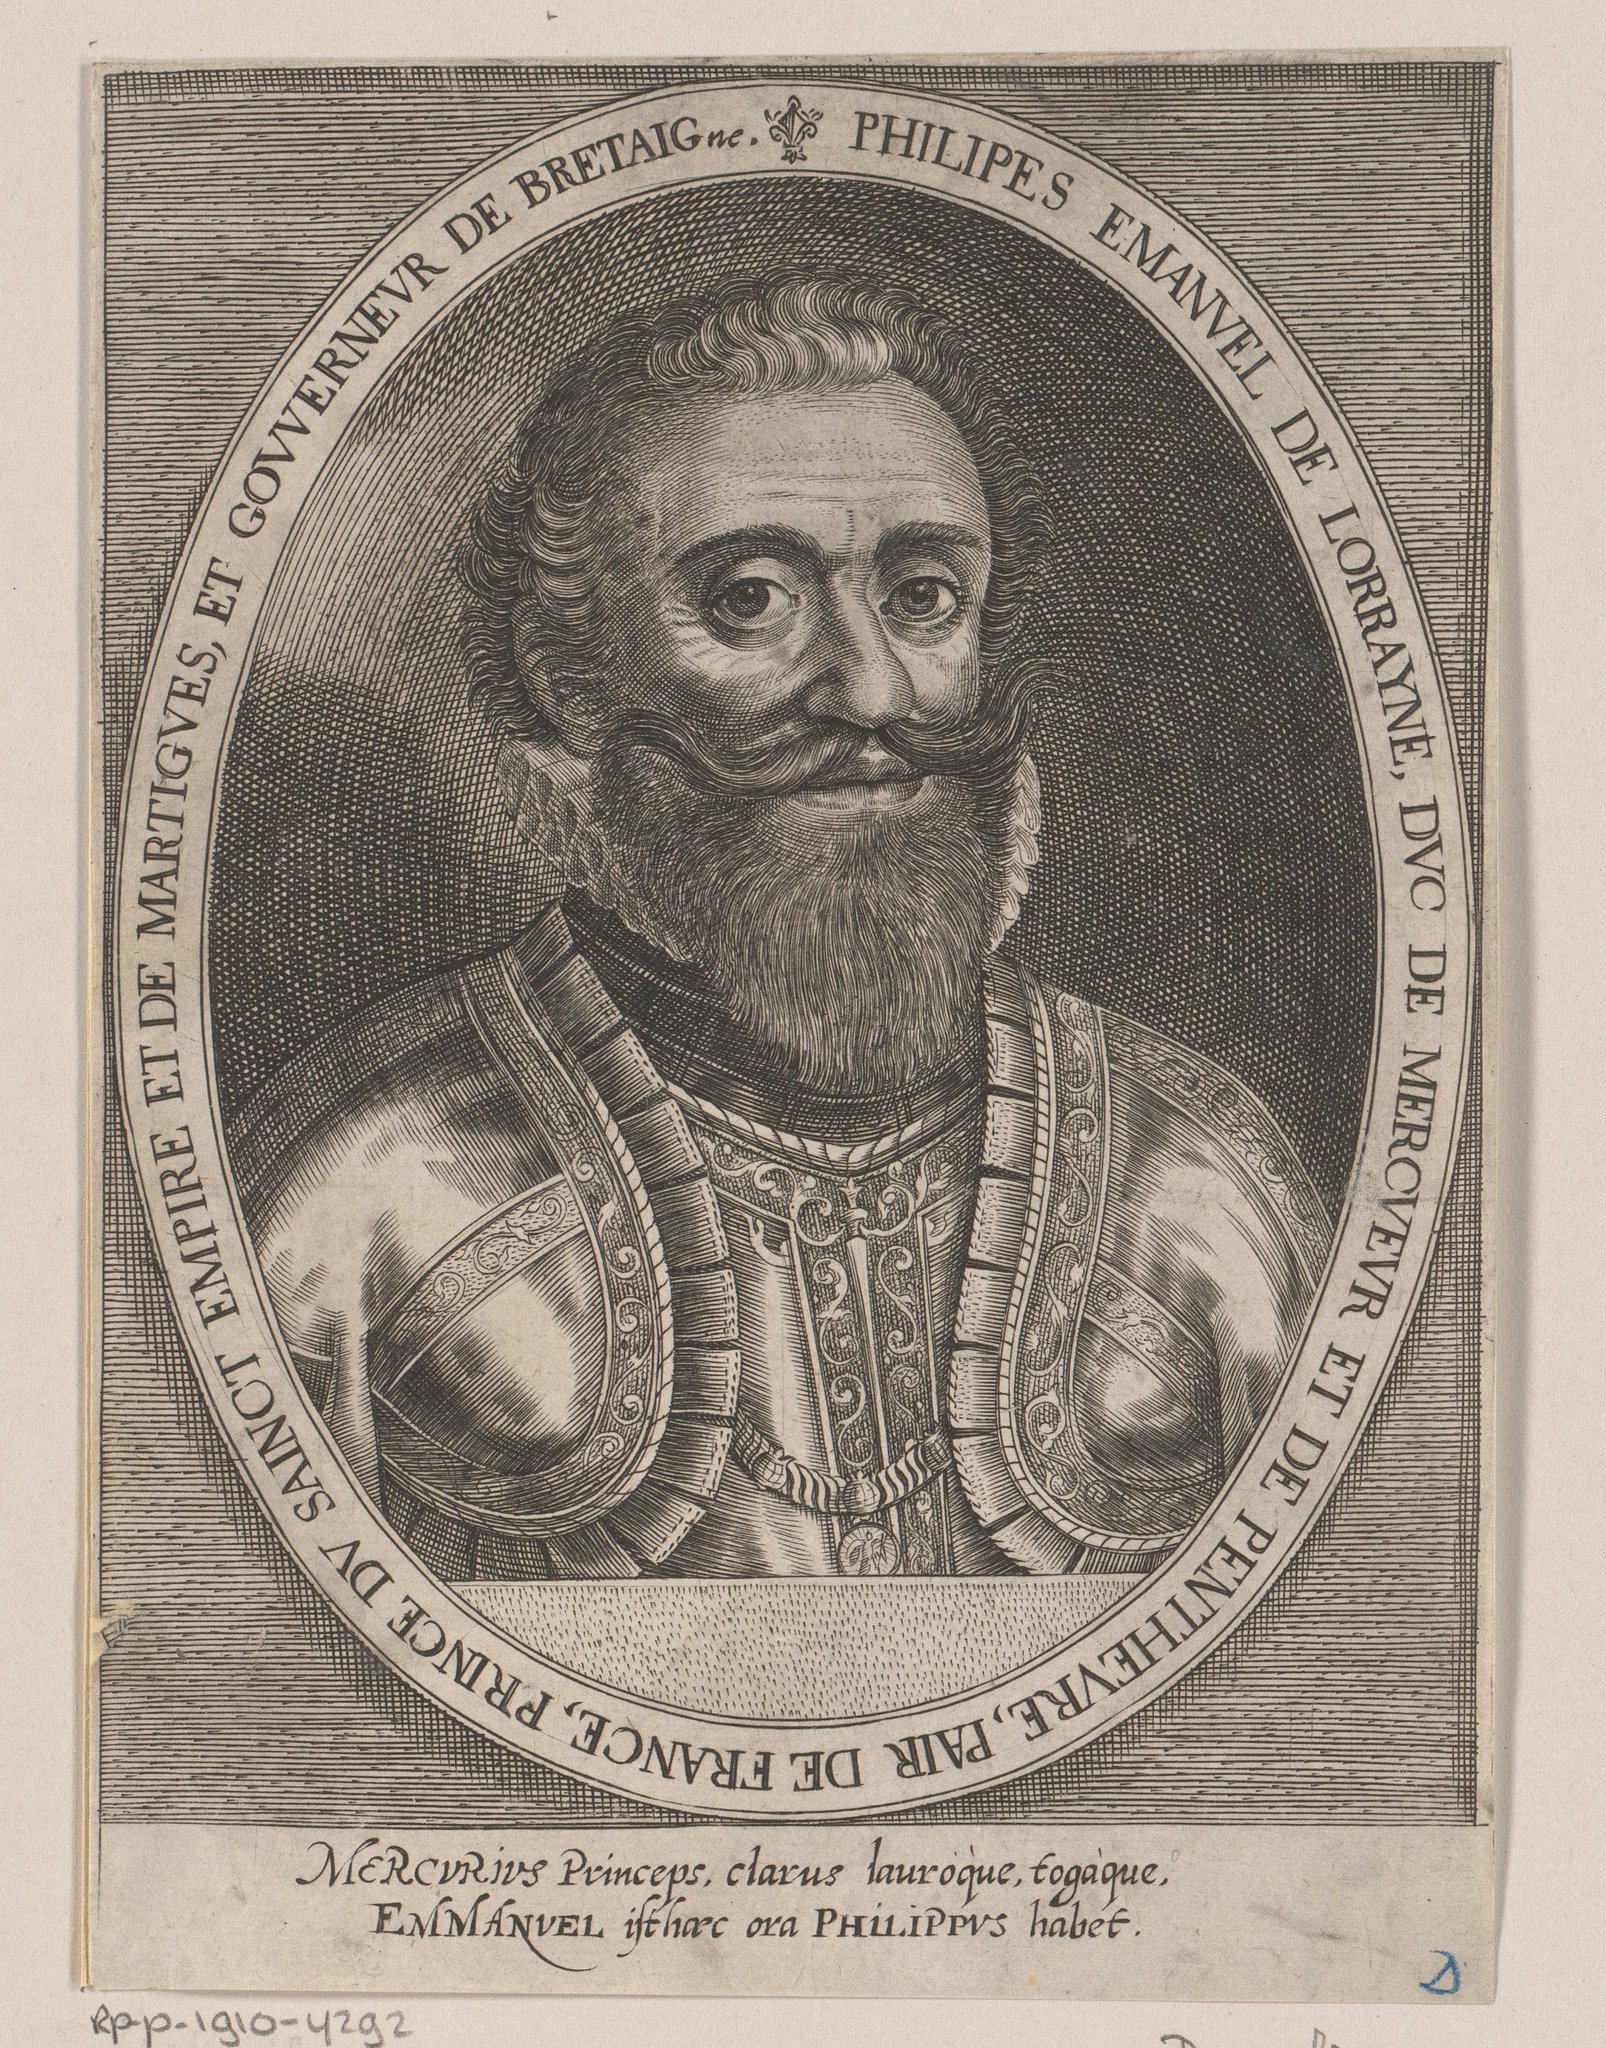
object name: book illustration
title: Atrium Heroicum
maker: dominicus custos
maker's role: print maker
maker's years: 1560-1615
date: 1600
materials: paper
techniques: engraving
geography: augsburg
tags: historical persons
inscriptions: collector's mark: Lugt 2228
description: Prent waarschijnlijk uit: Custos, Dominicus. Atrium heroicum caesarum (...). Augsburg: Dominicus Custos, 1600, dl. 2.